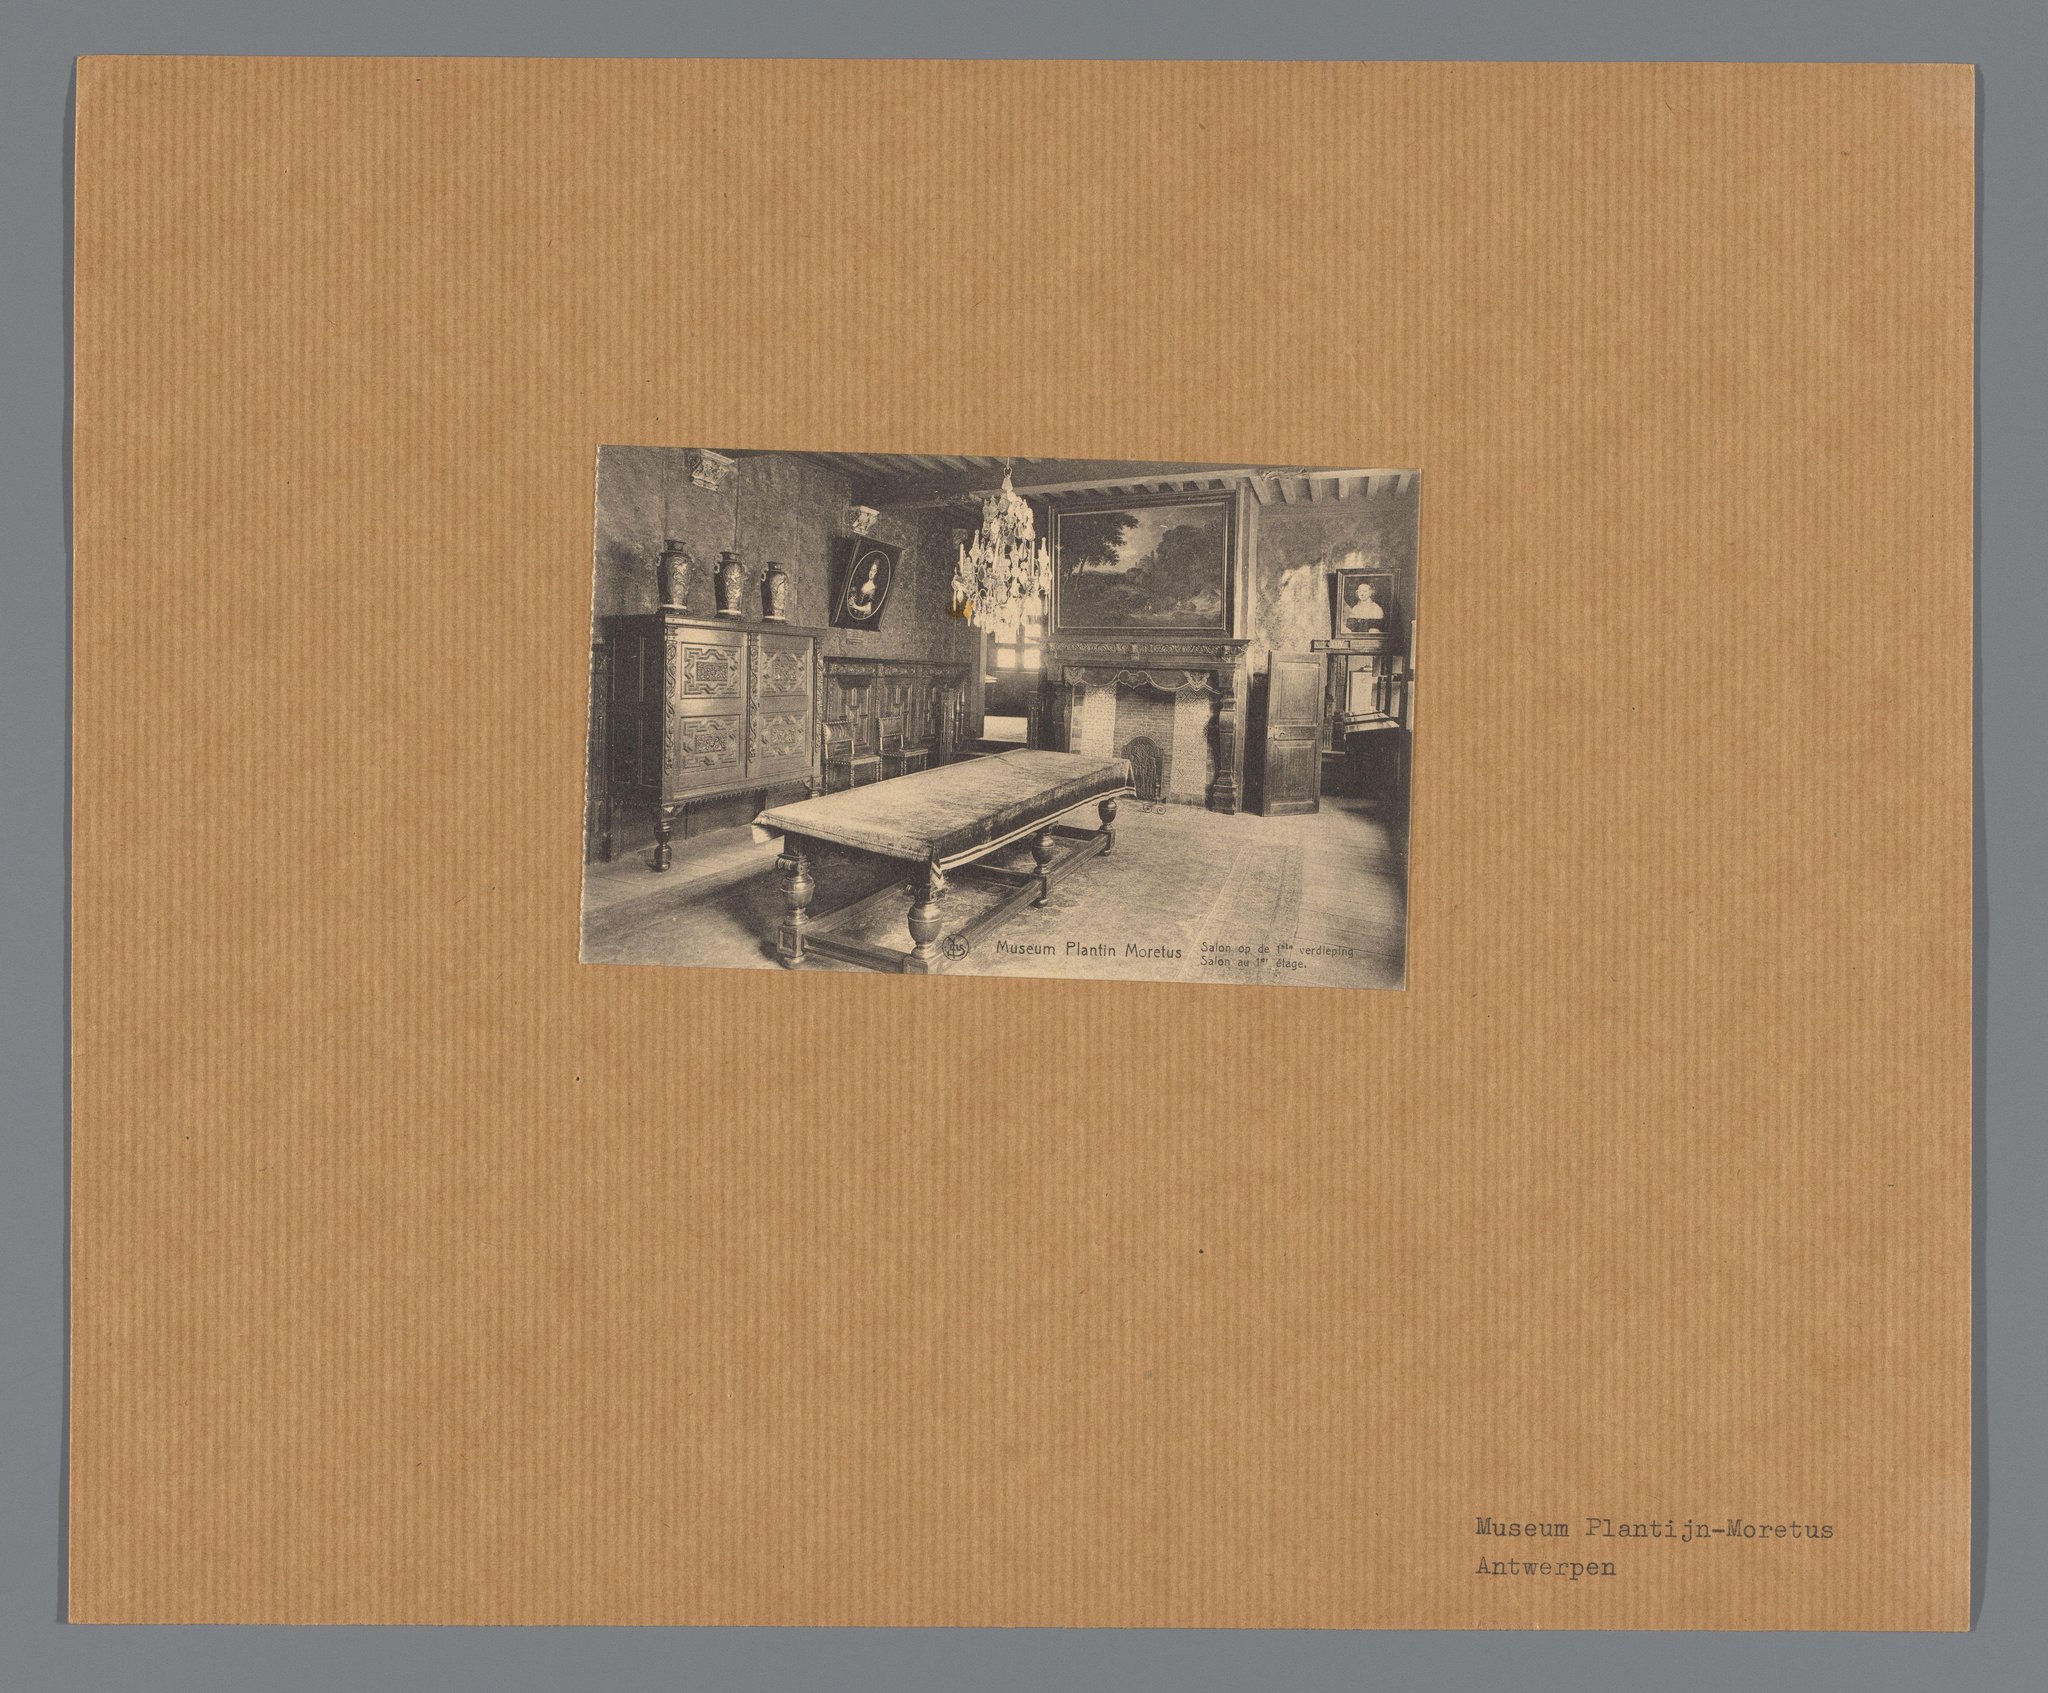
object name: photograph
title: Antwerpen. Museum Plantijn - Moretus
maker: Anonymous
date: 1860-1925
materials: photographic support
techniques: photograph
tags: museum plantin-moretus